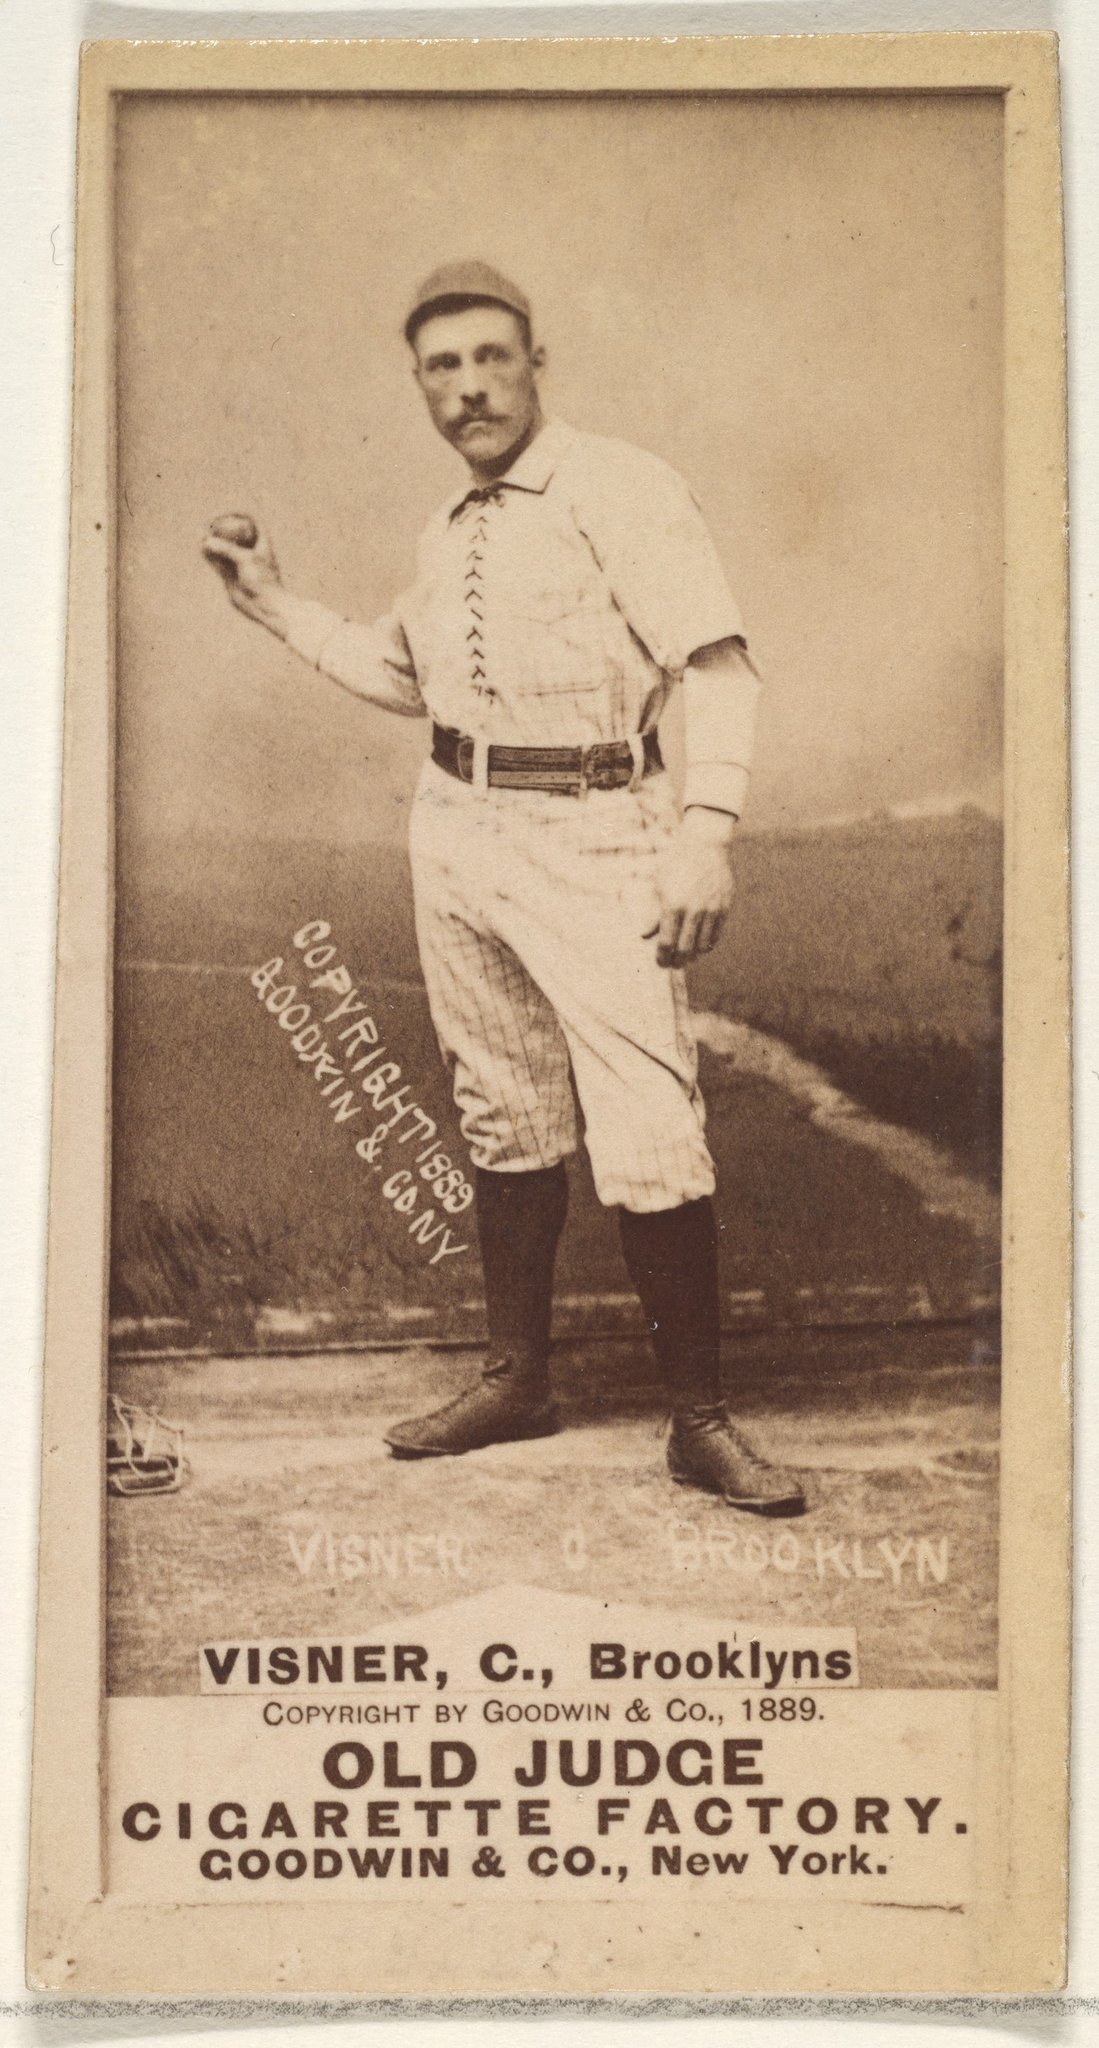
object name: baseball card, photograph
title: Visner, Catcher, Brooklyn Bridegrooms, from the Old Judge series (N172) for Old Judge Cigarettes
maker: goodwin & company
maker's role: publisher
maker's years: 1850-1950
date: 1889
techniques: albumen silver print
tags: men,portraits,baseball,athletes